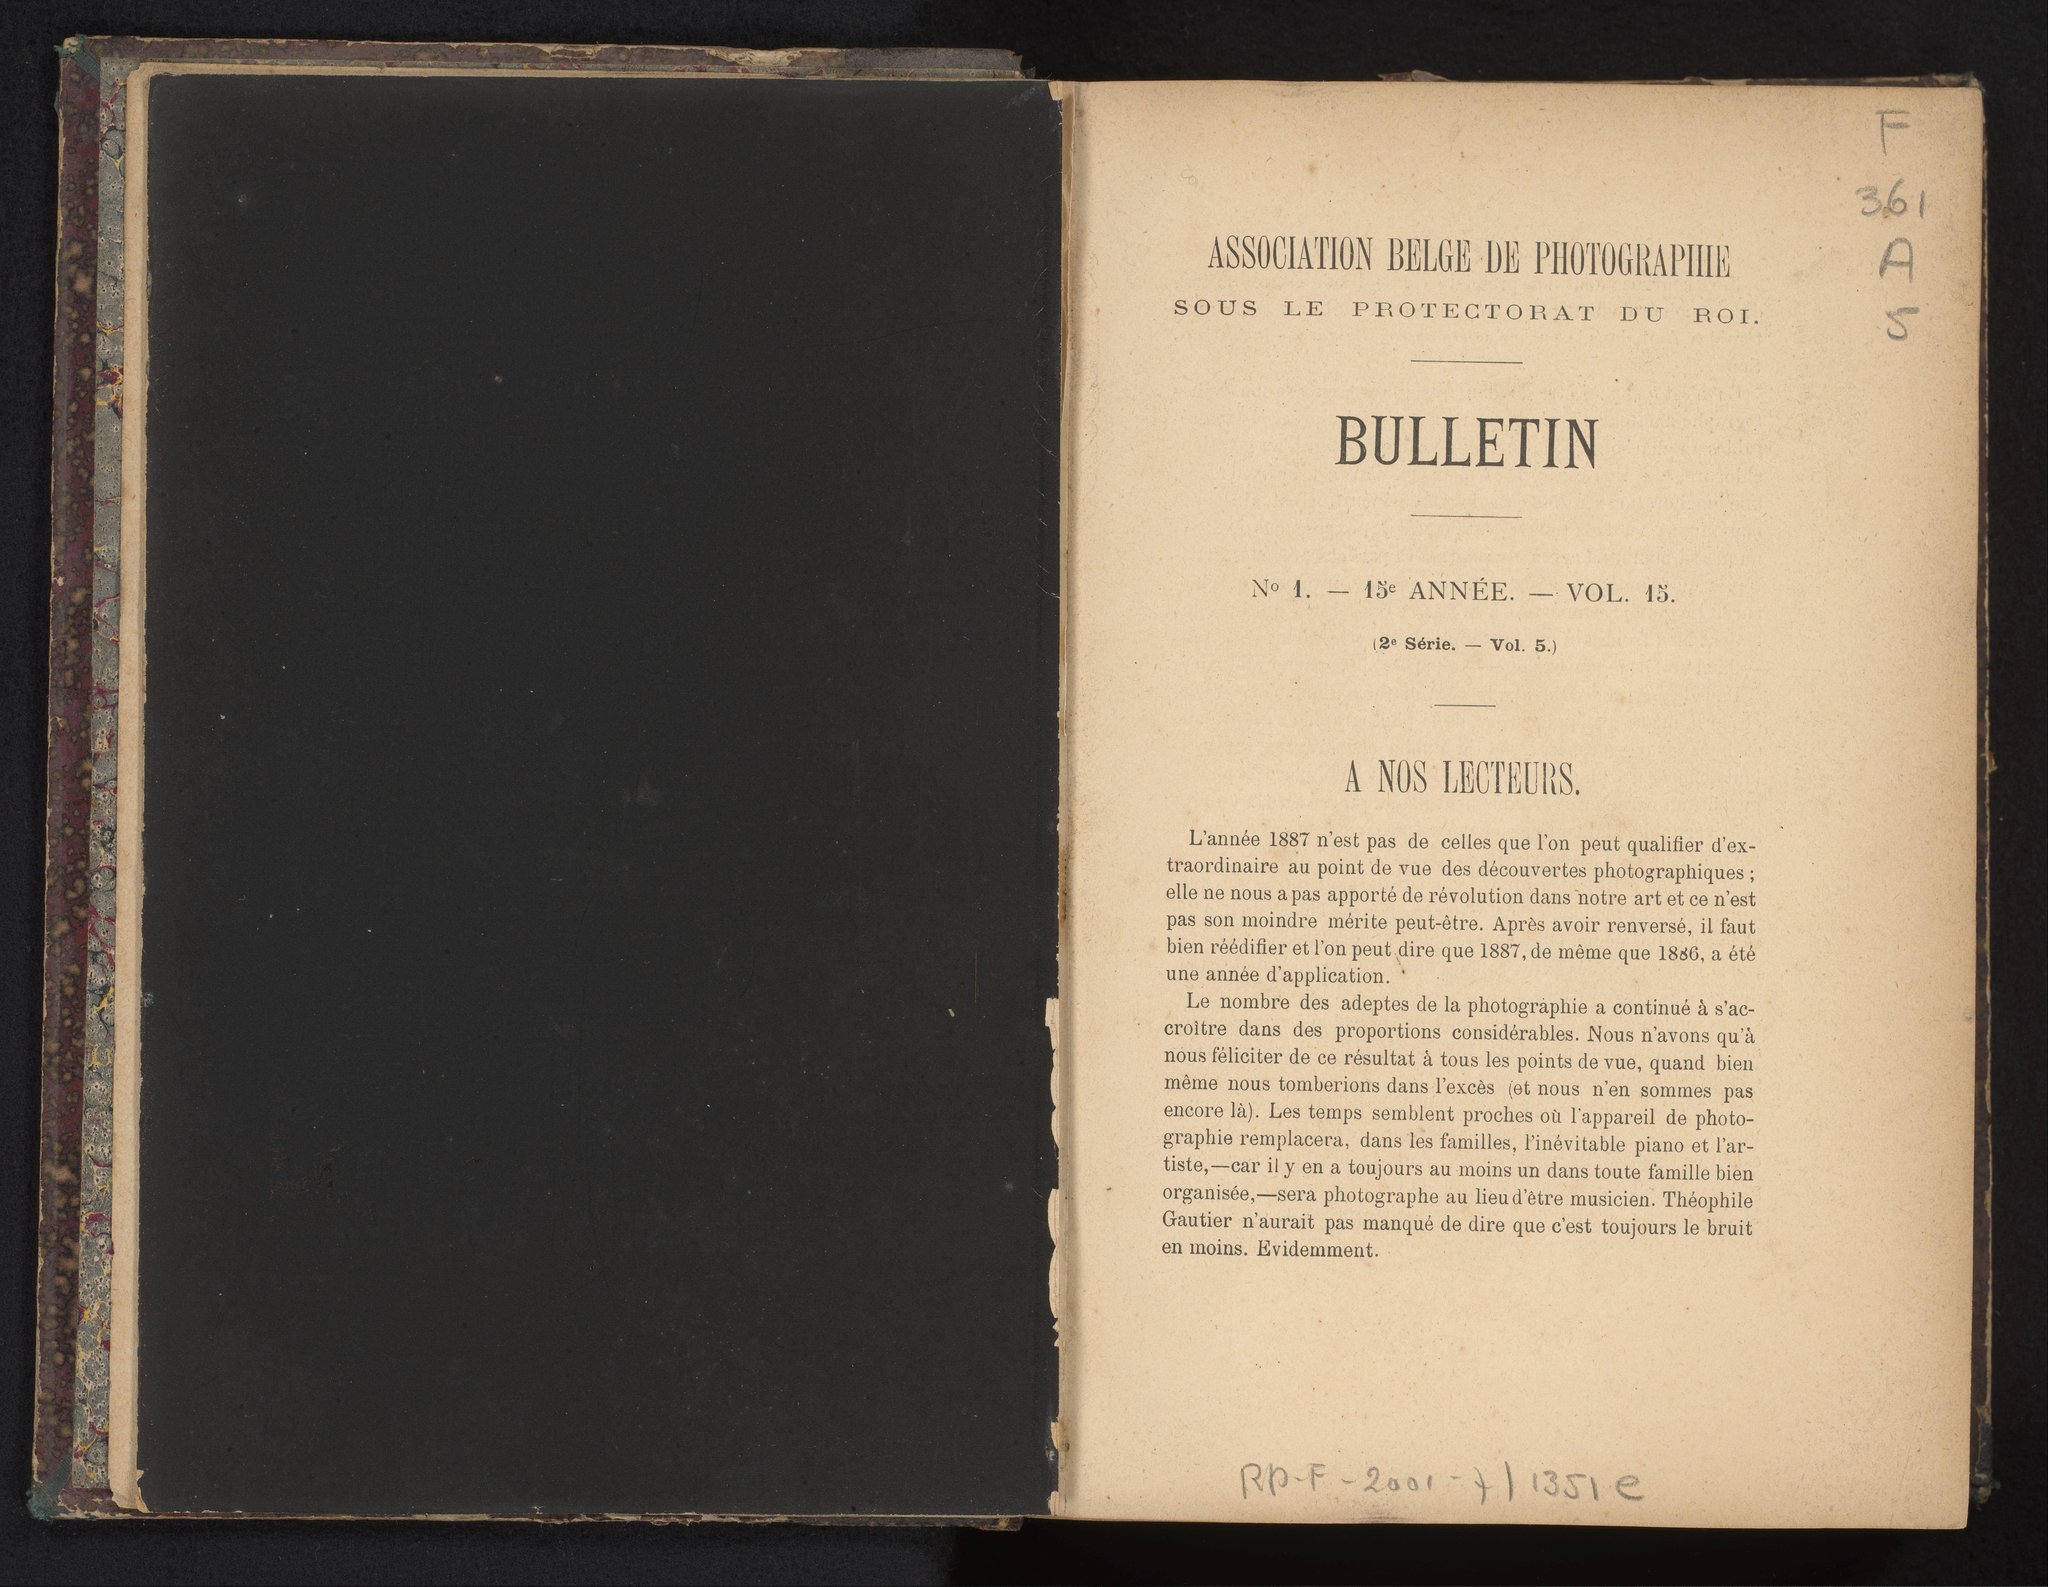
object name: book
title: Bulletin / Association belge de photographie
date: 1888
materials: cardboard, leather, paper, photographic support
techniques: marbled paper, albumen print, photograph, printing, marbling, woodburytype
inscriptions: annotation: ‘APR/1989’